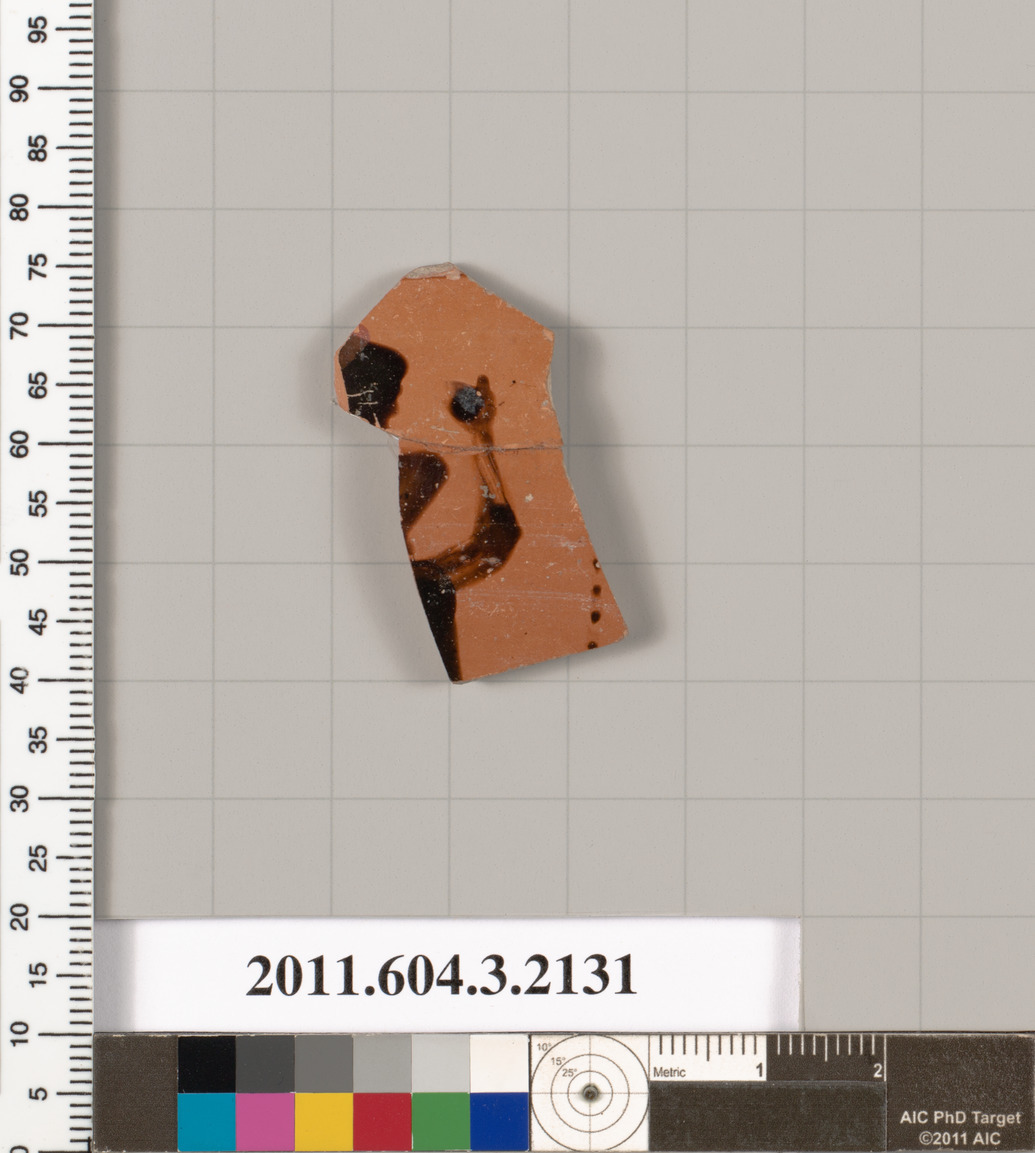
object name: kylix fragment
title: Terracotta fragment of a kylix (drinking cup)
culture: greek, attic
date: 500-468 BCE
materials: terracotta